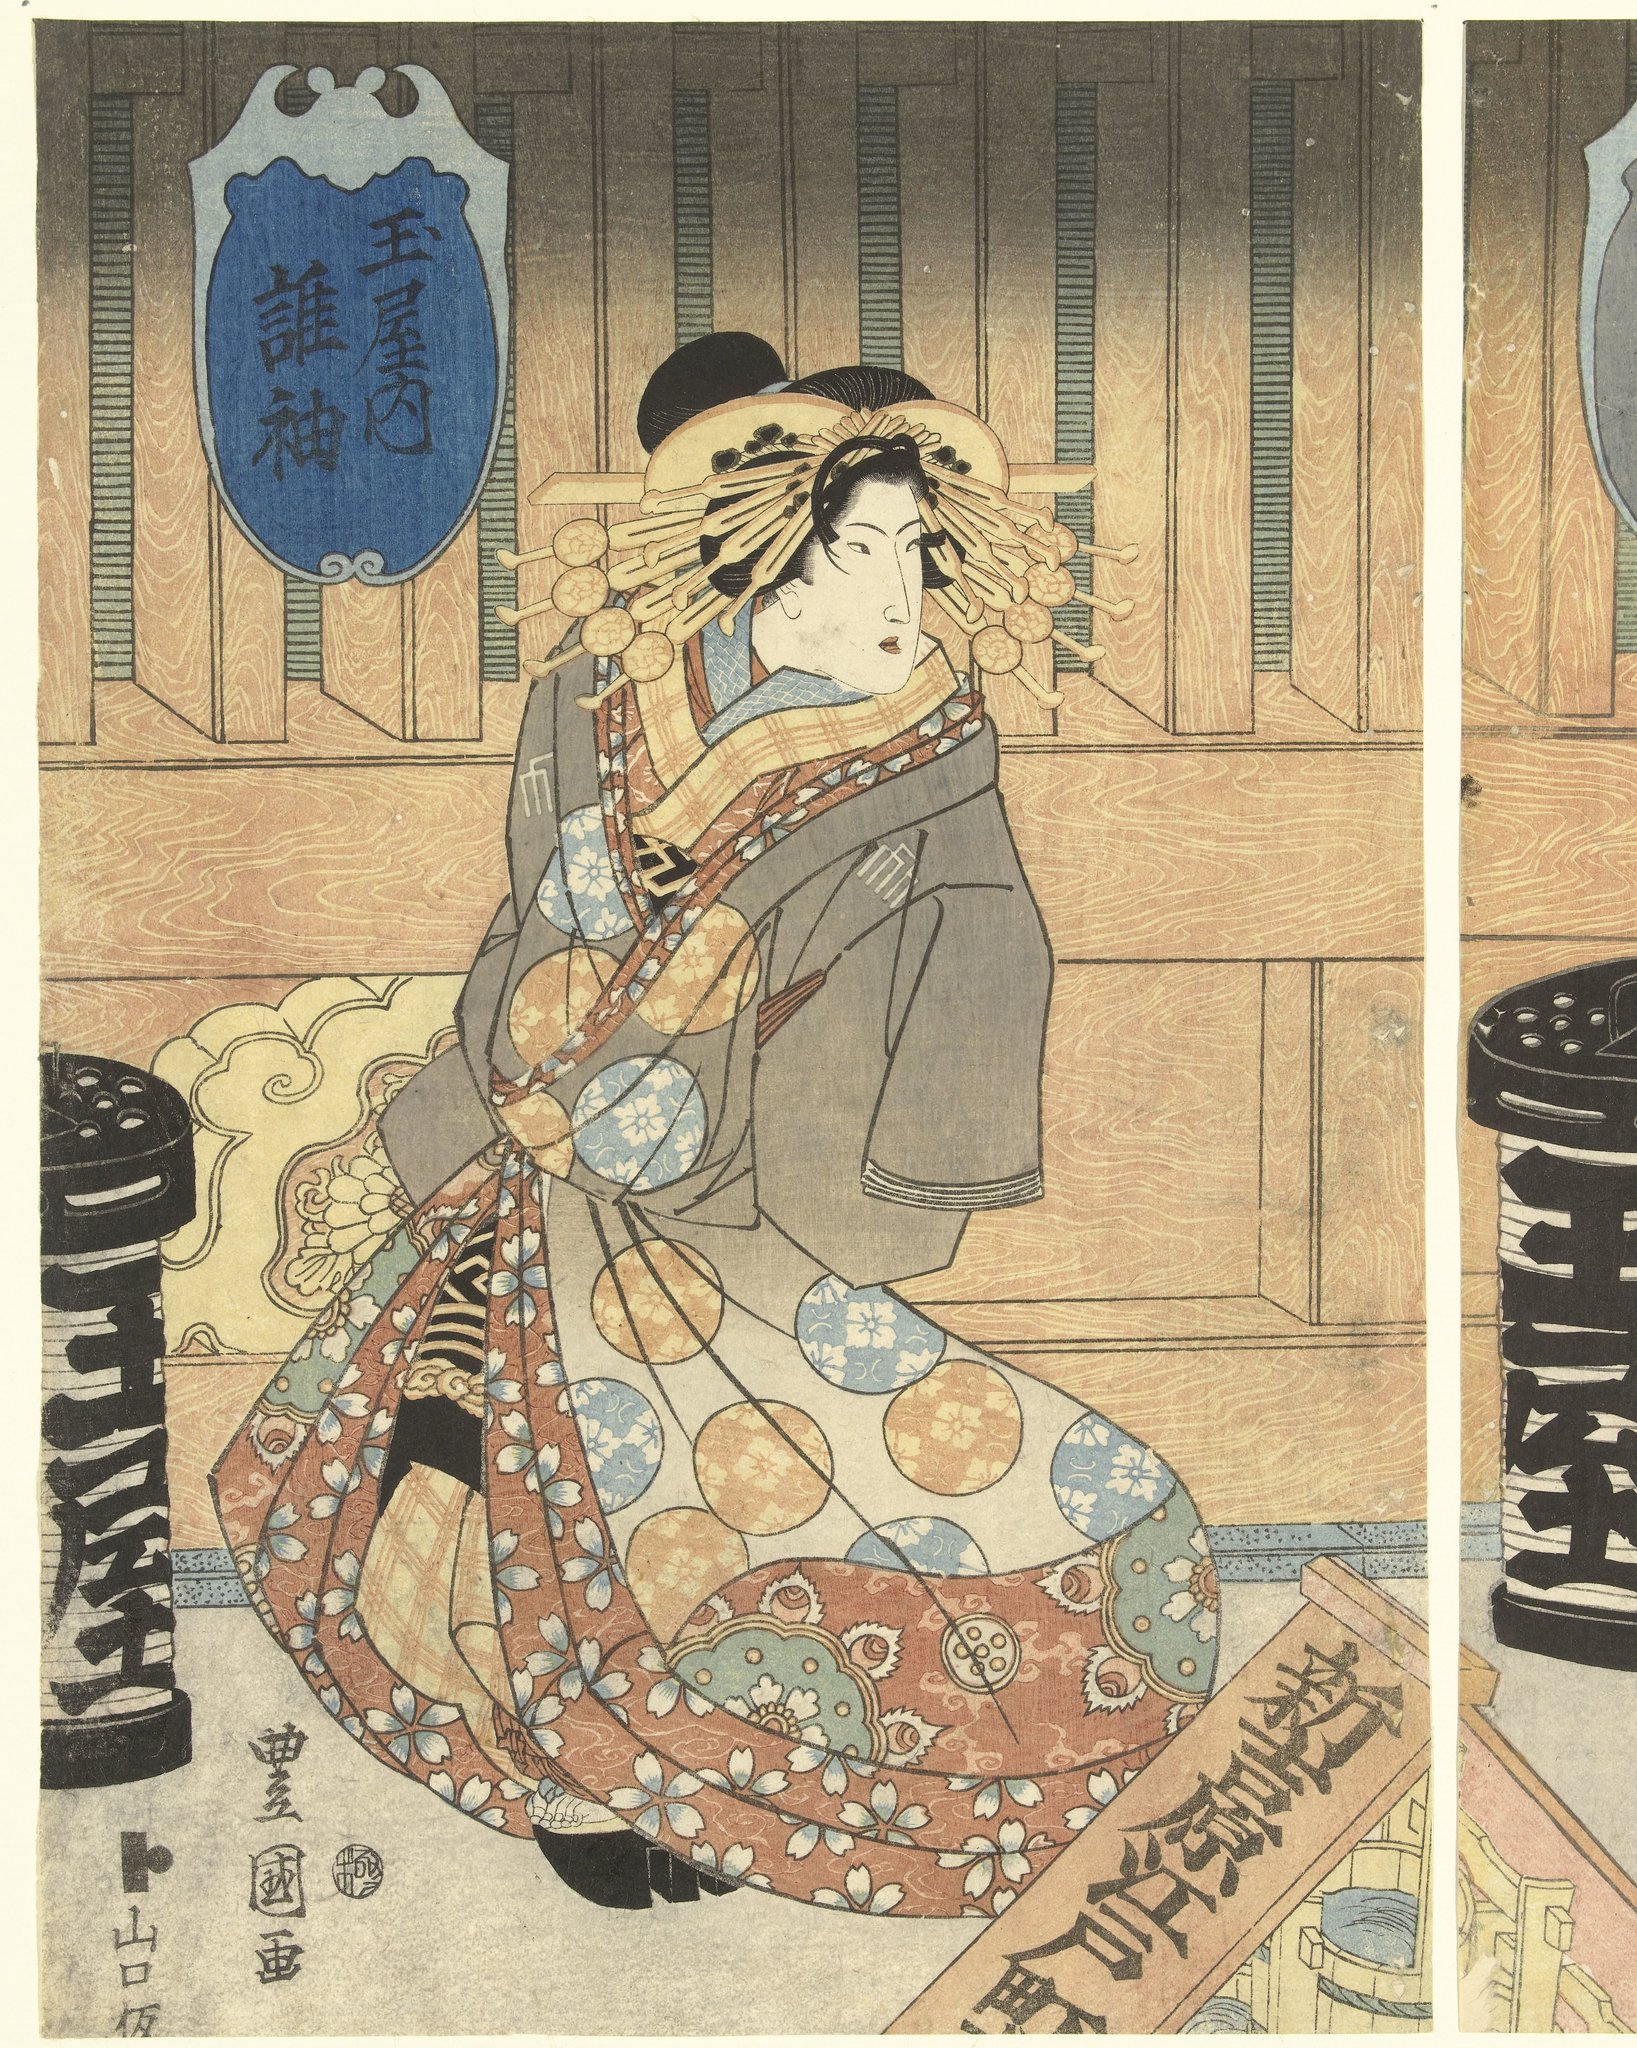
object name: print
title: Drie courtisanes uit het Tamaya huis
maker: utagawa toyokuni (ii)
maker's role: print maker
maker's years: 1777-1835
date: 1828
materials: paper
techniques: woodcut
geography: japan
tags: courtesan, hetaera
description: Courtisane in kimono met gestileerde bloempatronen, omkijkend, staand bij grote zwart-witte lantaarn tegen houten wand.